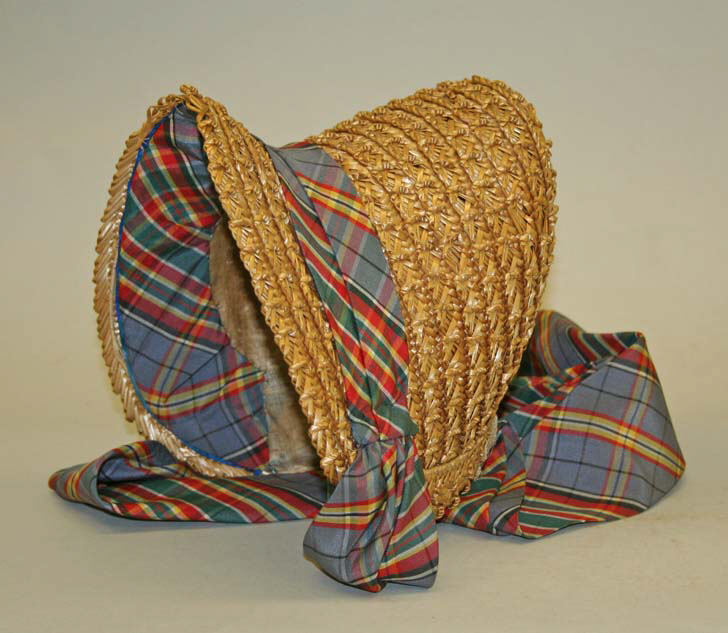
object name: bonnet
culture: american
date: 1868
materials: fiber